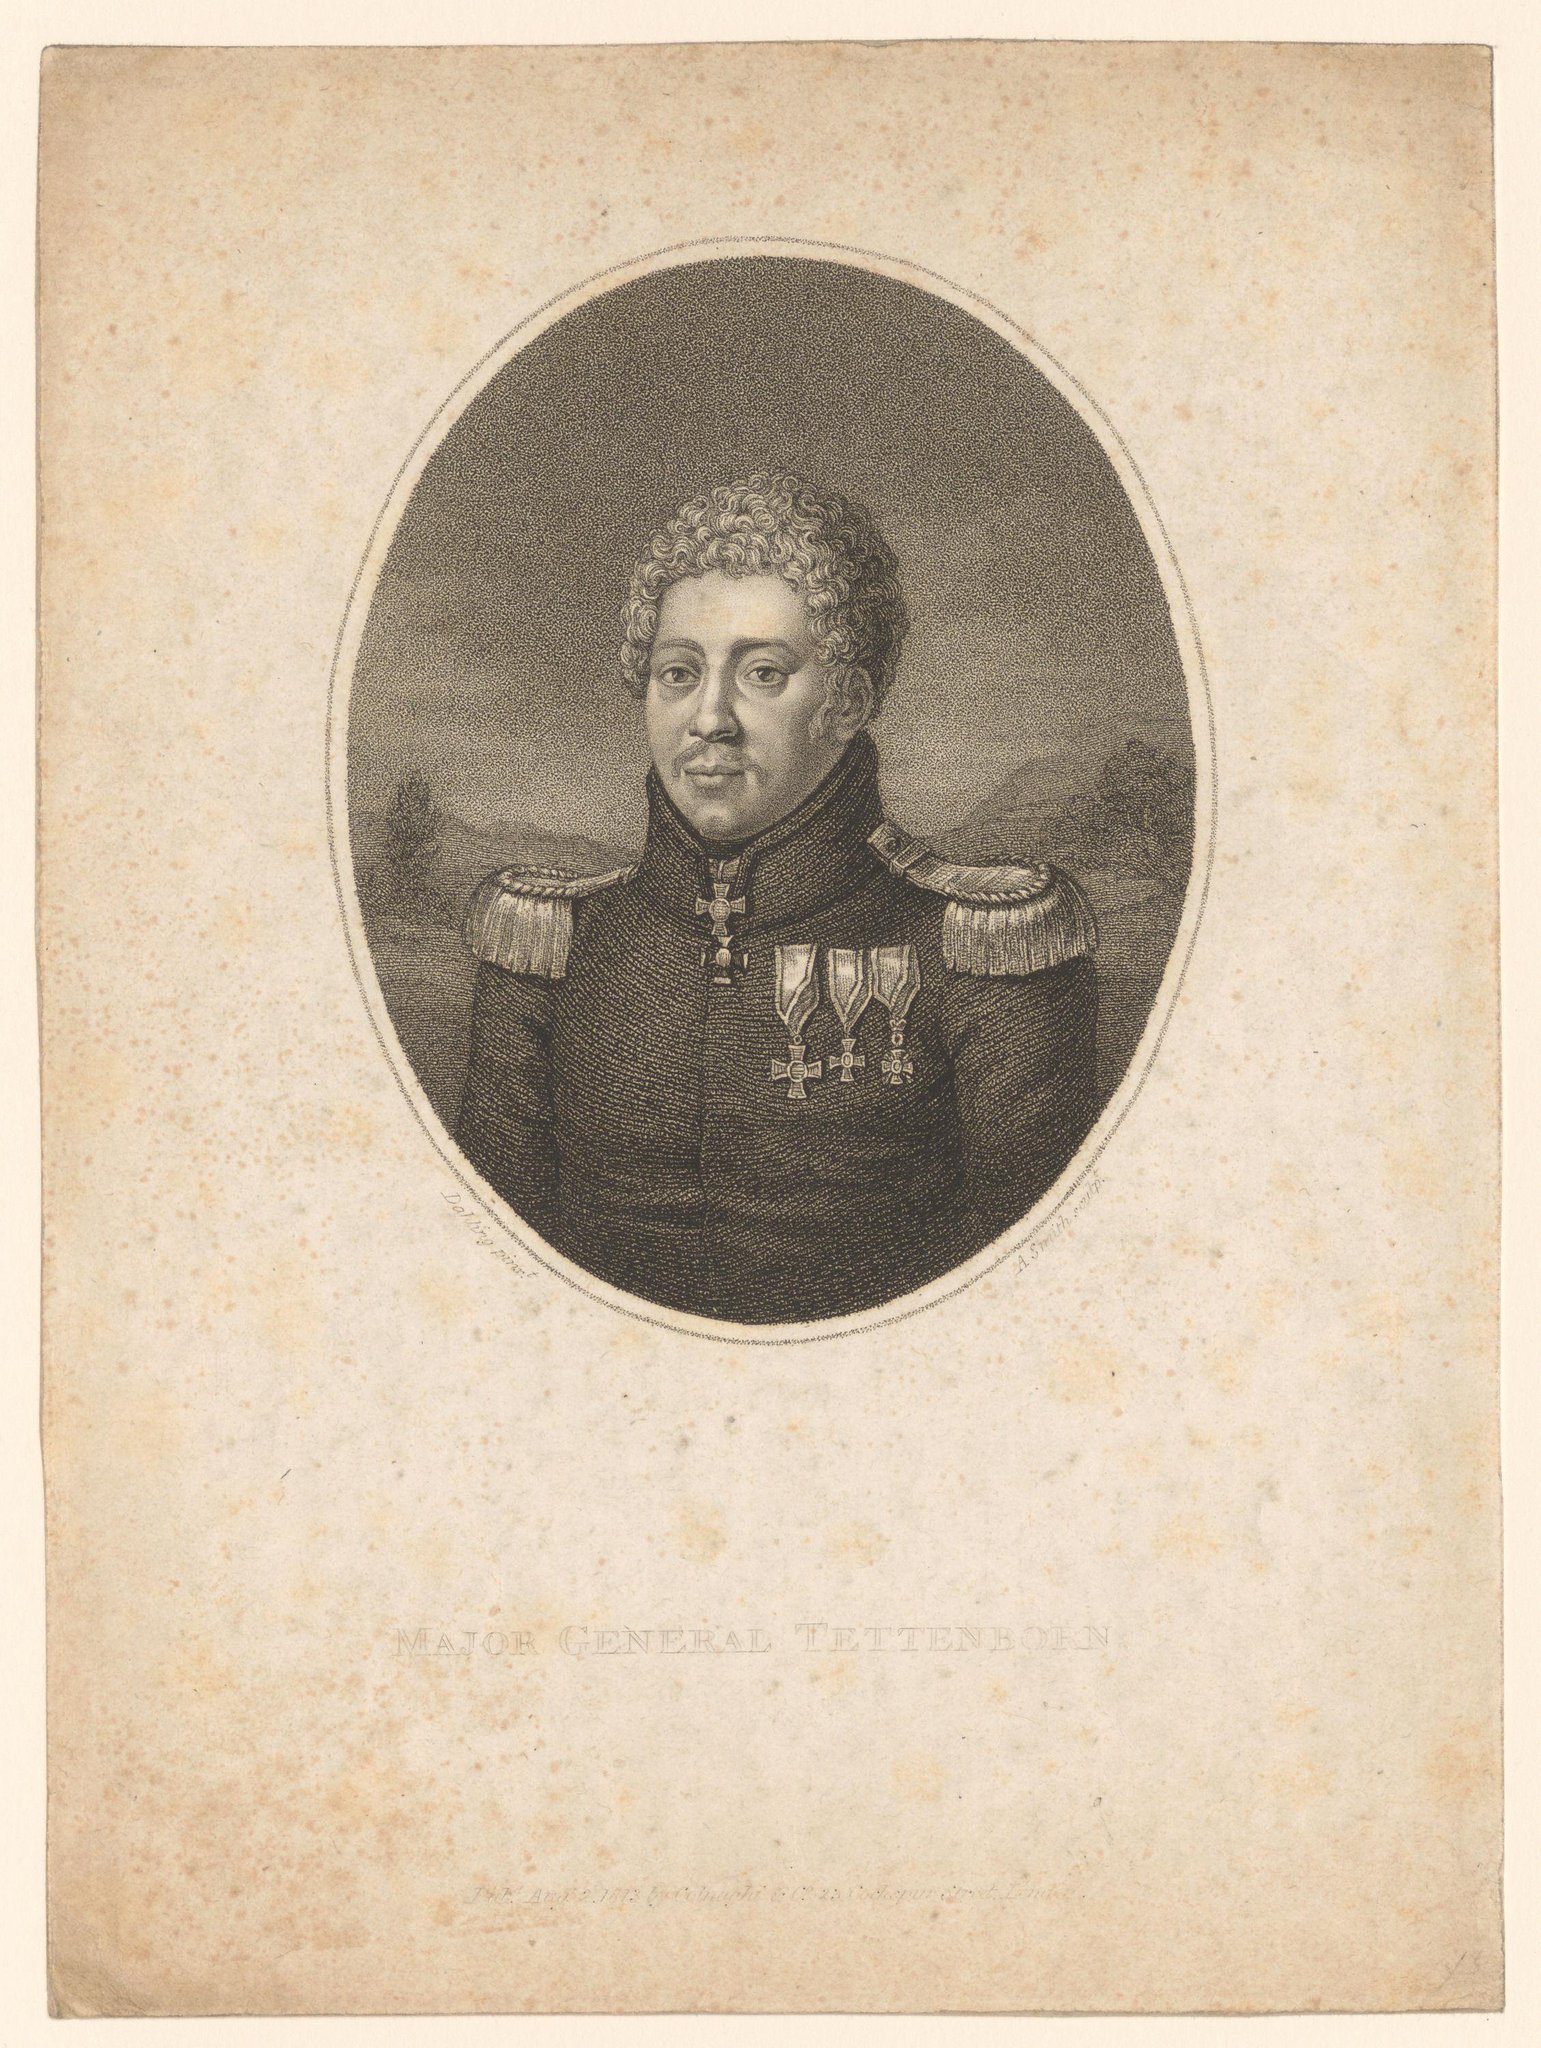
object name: print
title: Portret van Friedrich Carl von Tettenborn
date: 1808-1813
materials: paper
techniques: engraving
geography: great britain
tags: vienna, commander-in-chief, general, marshal, historical persons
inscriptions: collector's mark: Lugt 2228